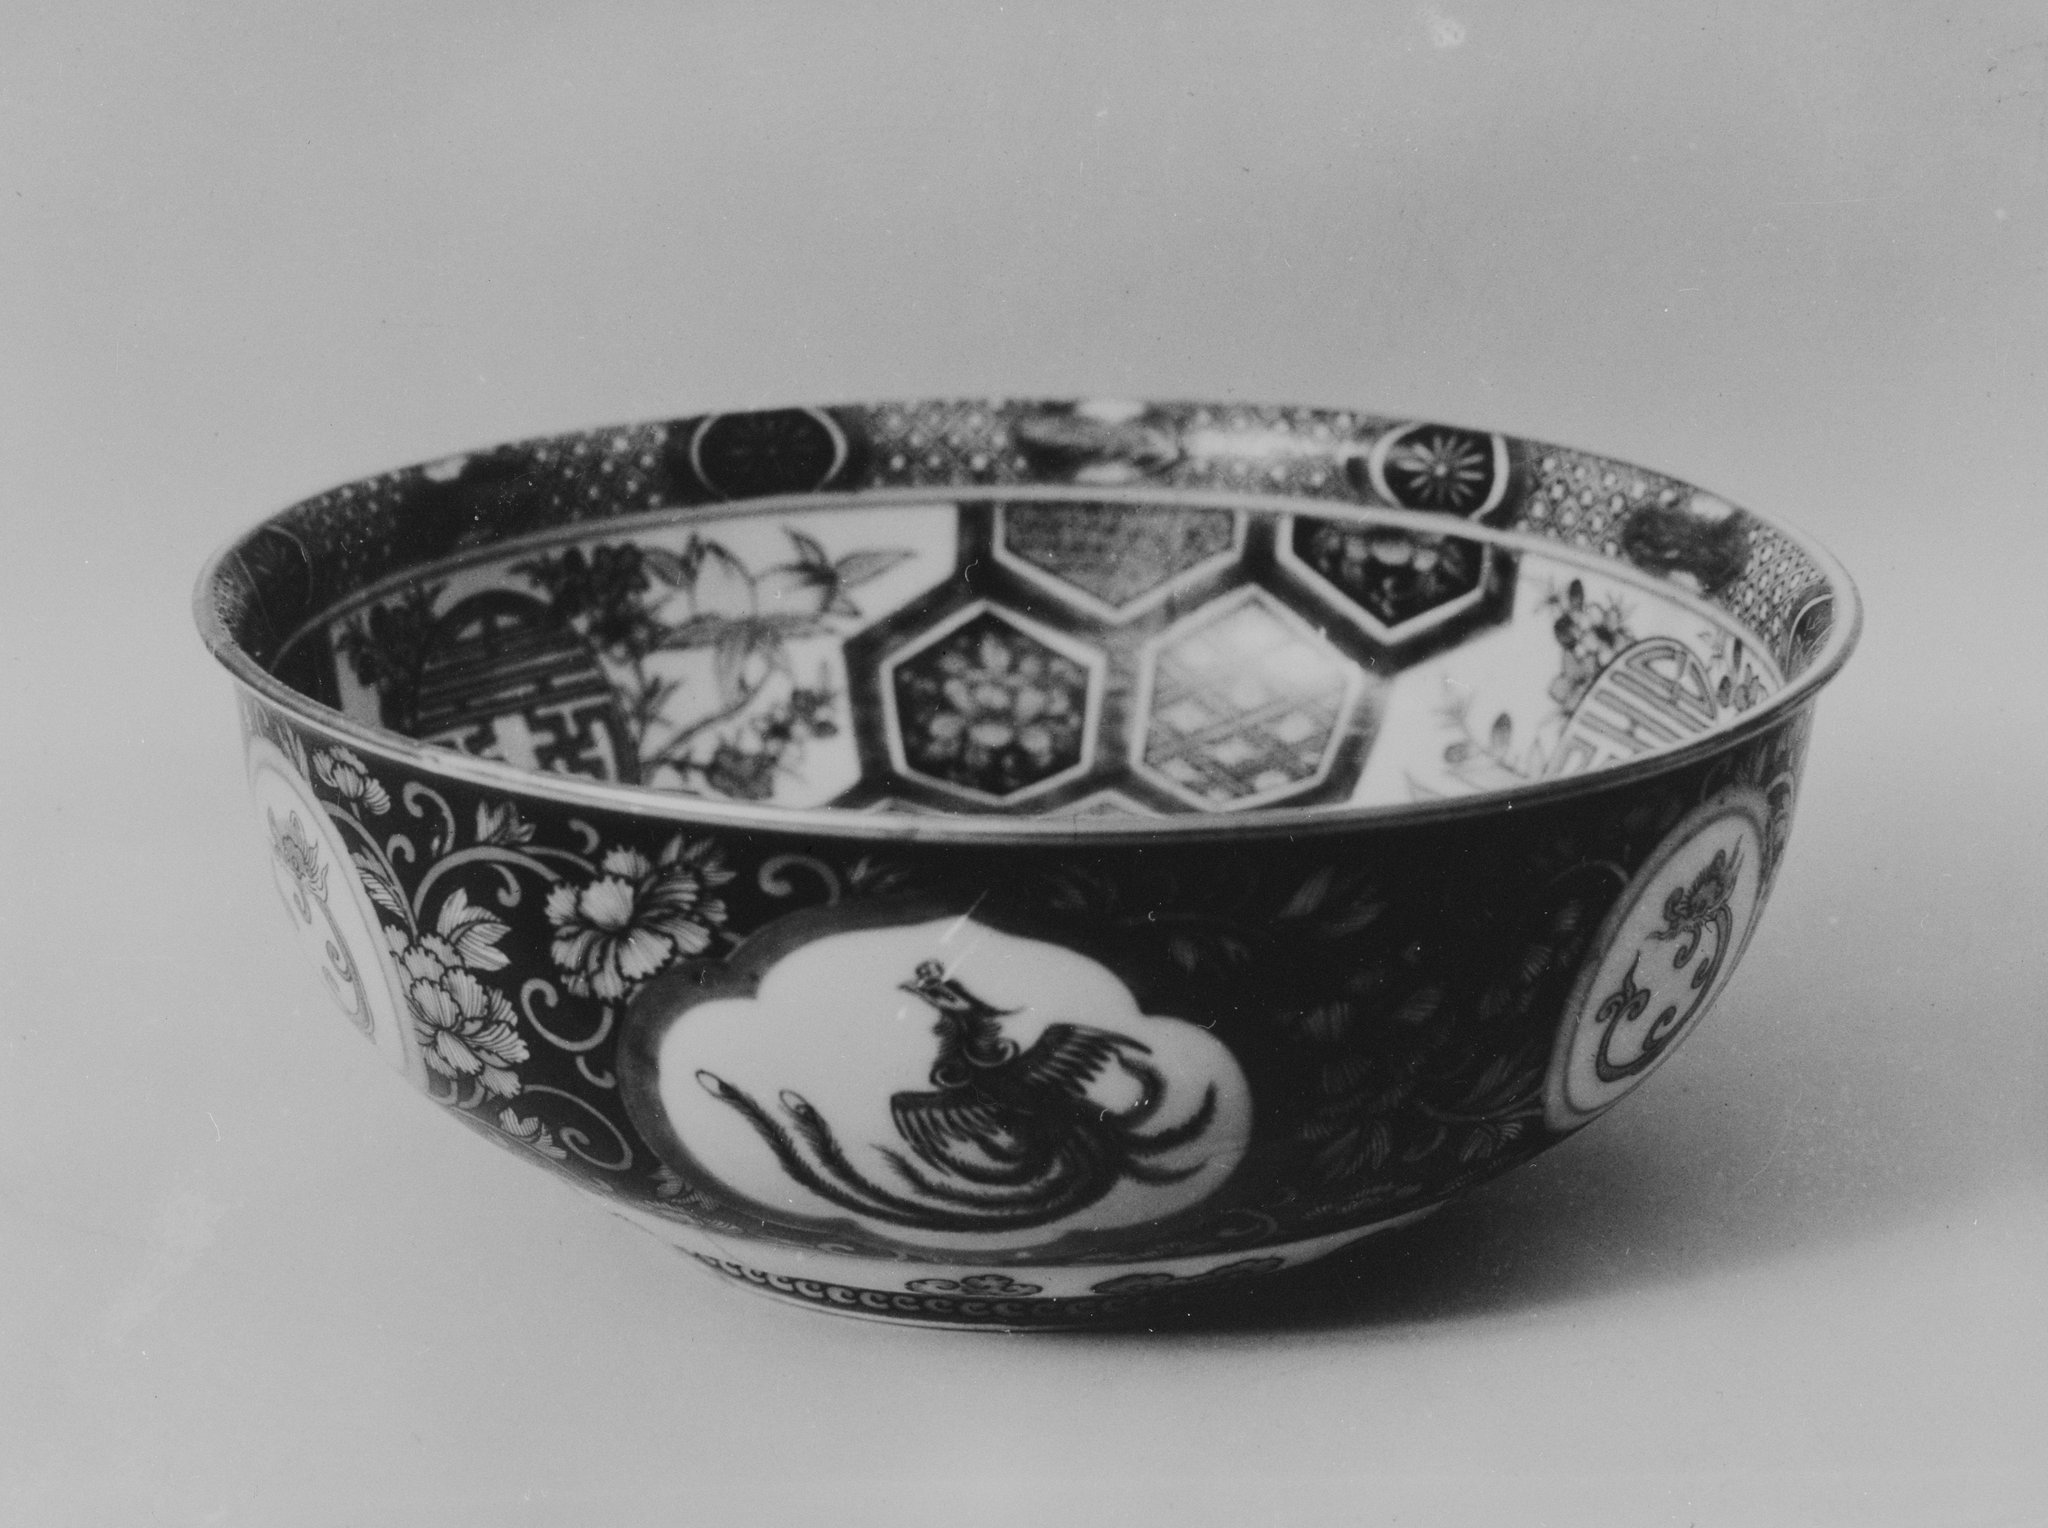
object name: bowl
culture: japanese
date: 1780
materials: enamel, porcelain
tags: phoenix